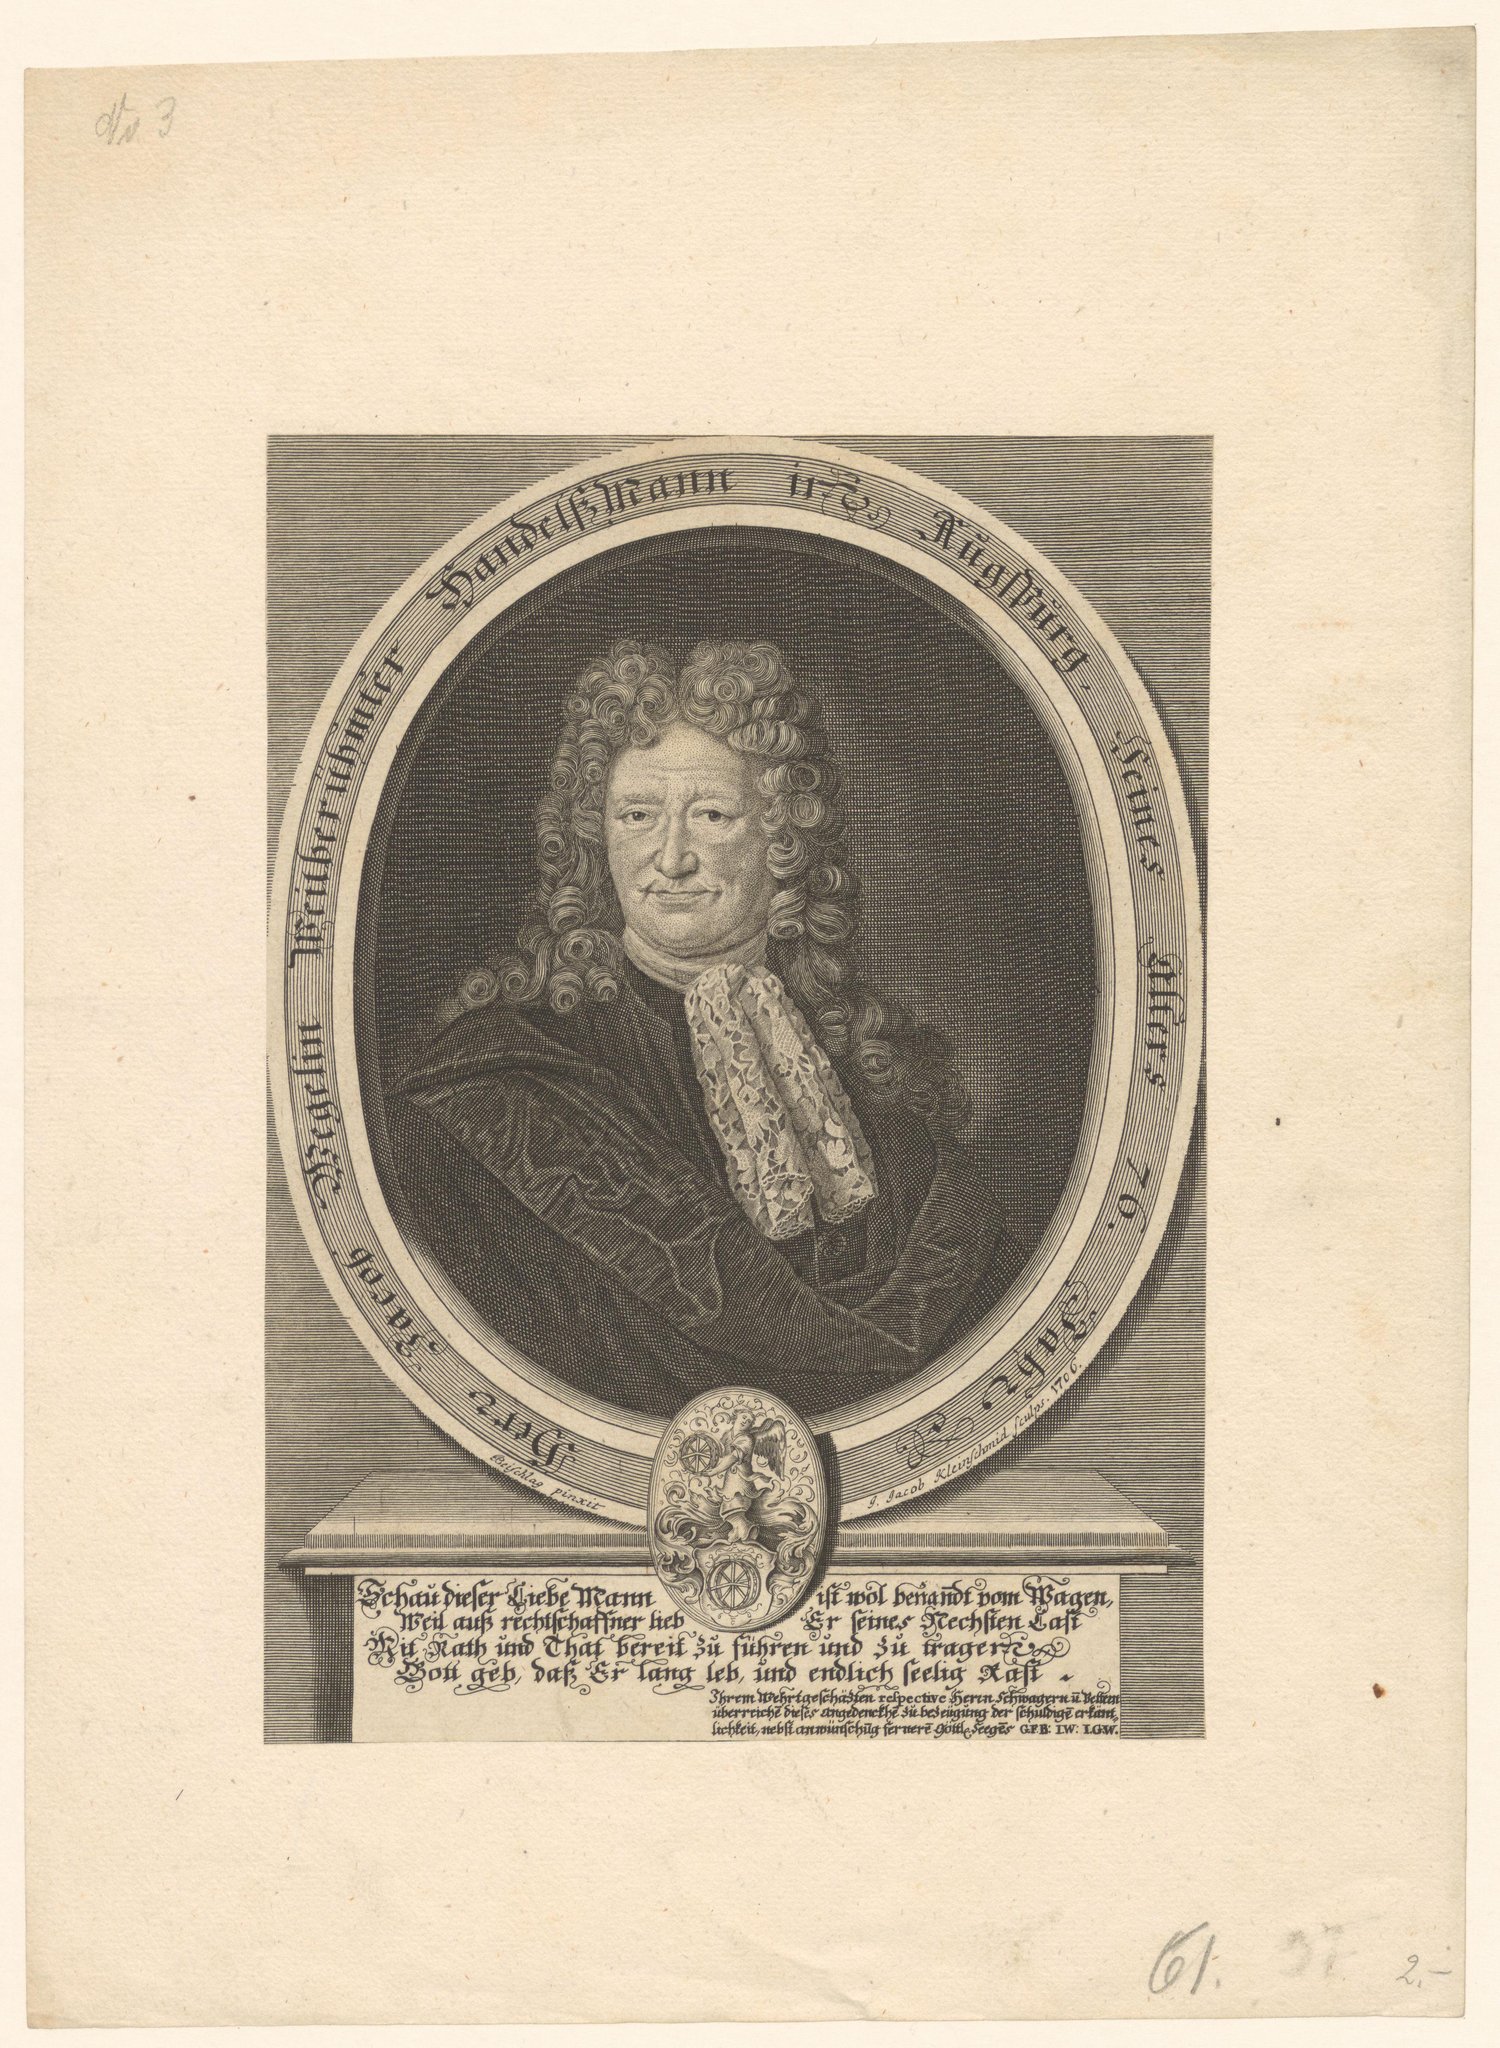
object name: print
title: Portret van Jacob Wegelin op 76-jarige leeftijd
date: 1706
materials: paper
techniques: engraving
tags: historical persons, merchant, salesman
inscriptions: collector's mark: Lugt 2228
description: Tekst in het Duits in de omlijsting en in de ondermarge.